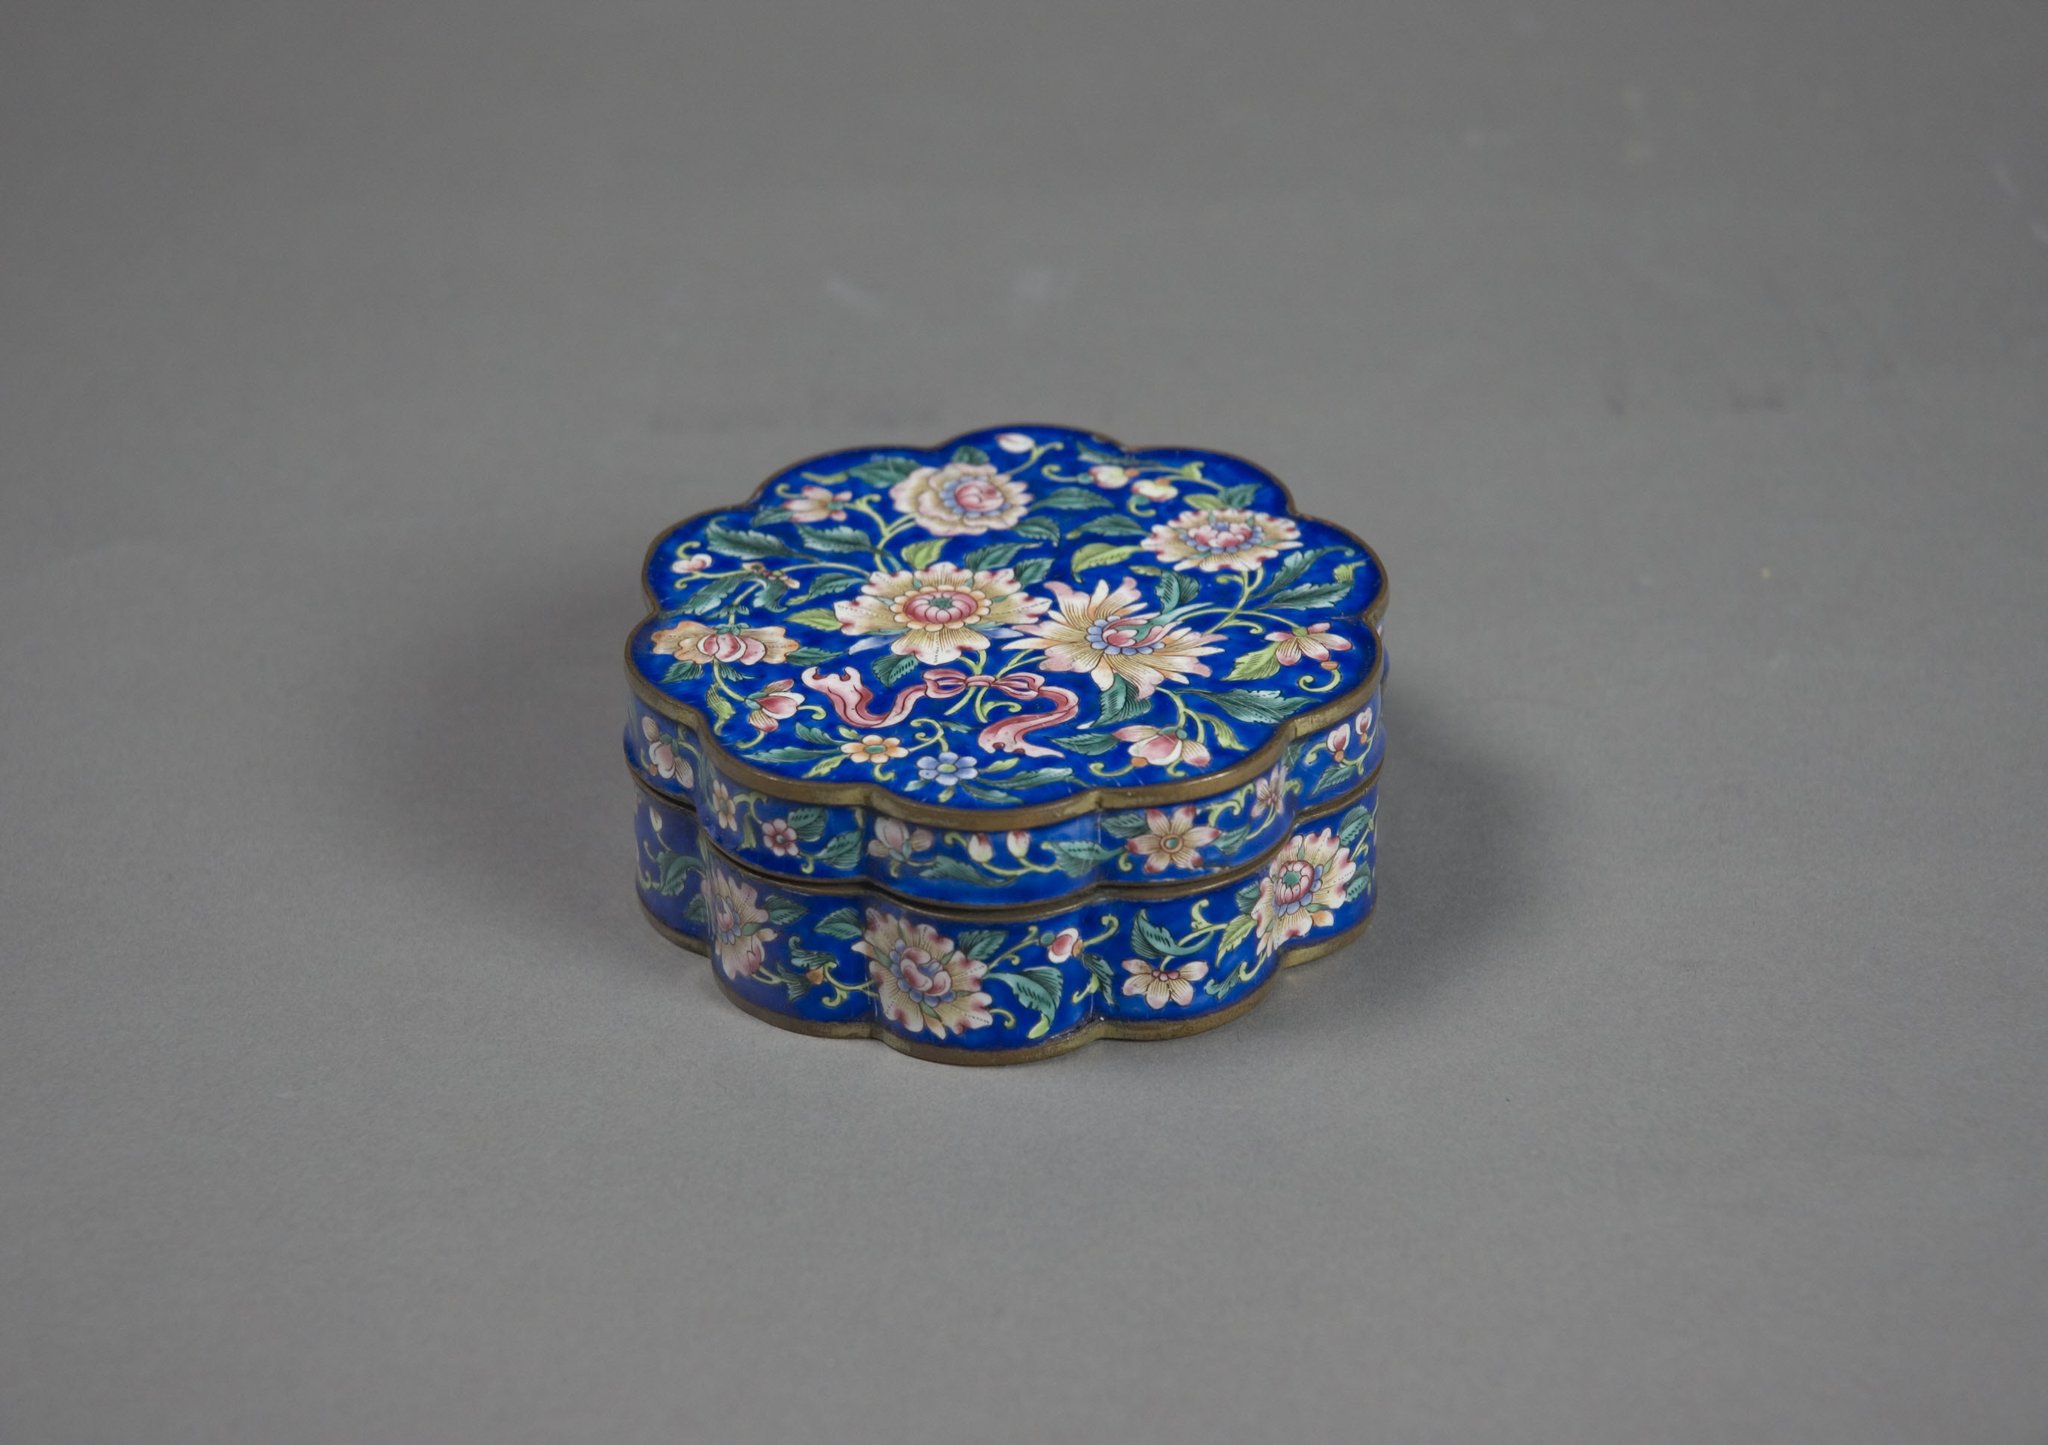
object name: box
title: Box with Floral Scrolls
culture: chinese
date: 1701-1800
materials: copper, enamel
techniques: painting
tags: flowers